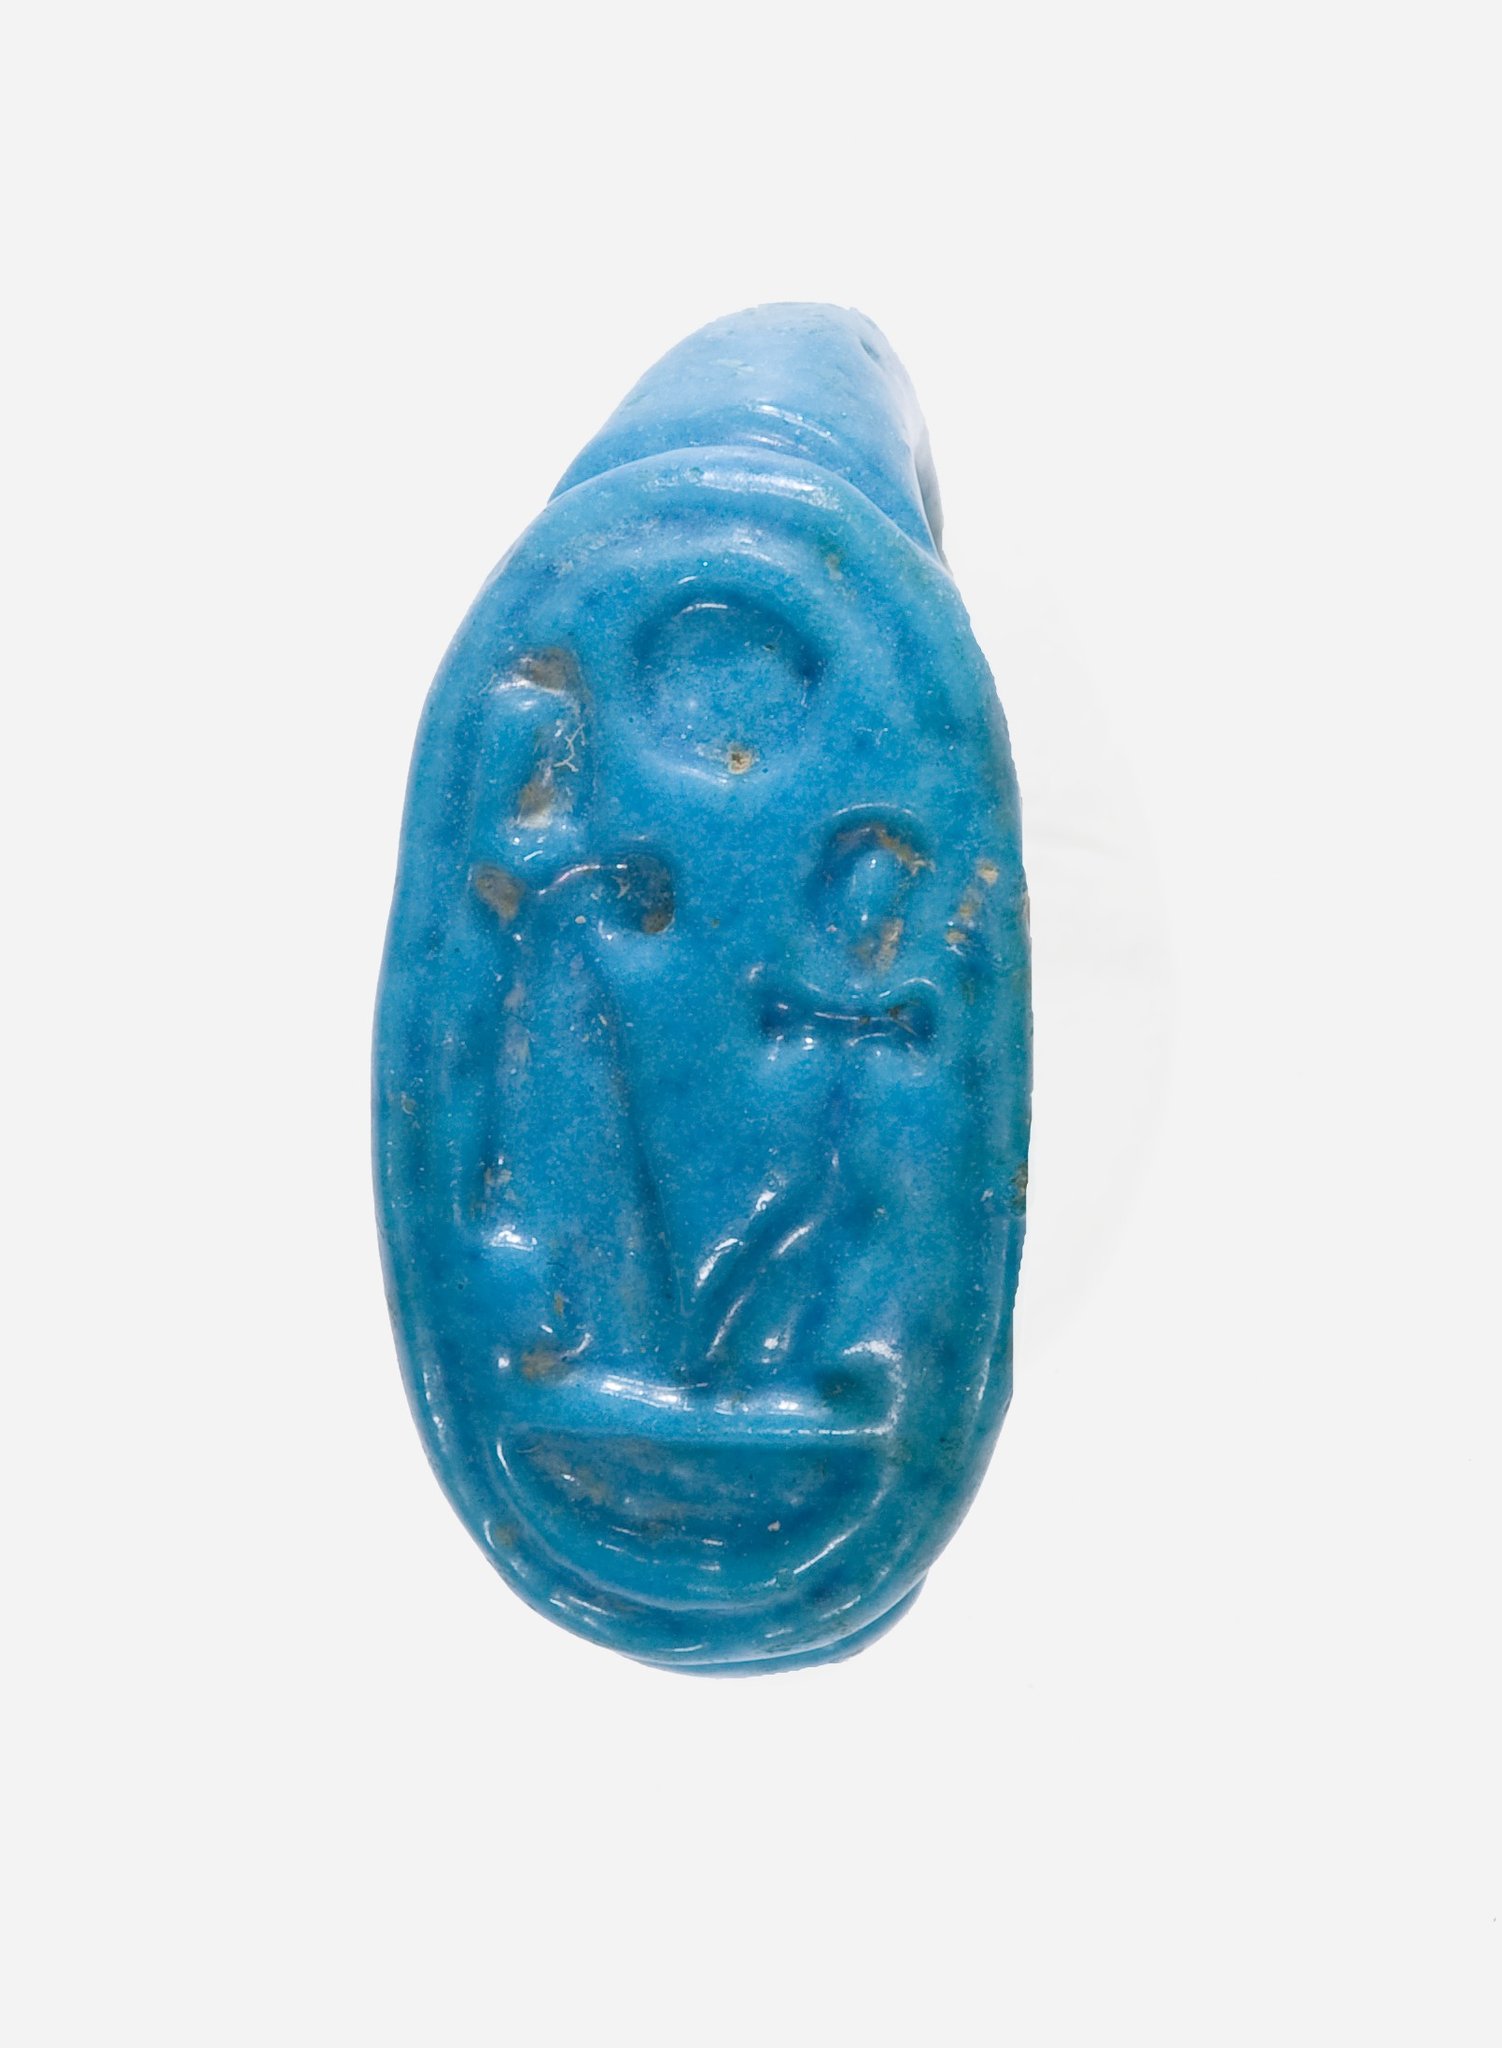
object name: ring, amenhotep iii, nebmaatre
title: Ring Inscribed with the Throne Name of Amenhotep III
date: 1390-1352 BCE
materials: faience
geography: egypt